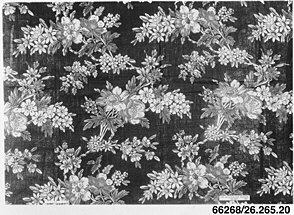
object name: piece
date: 1775-1780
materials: cotton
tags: flowers